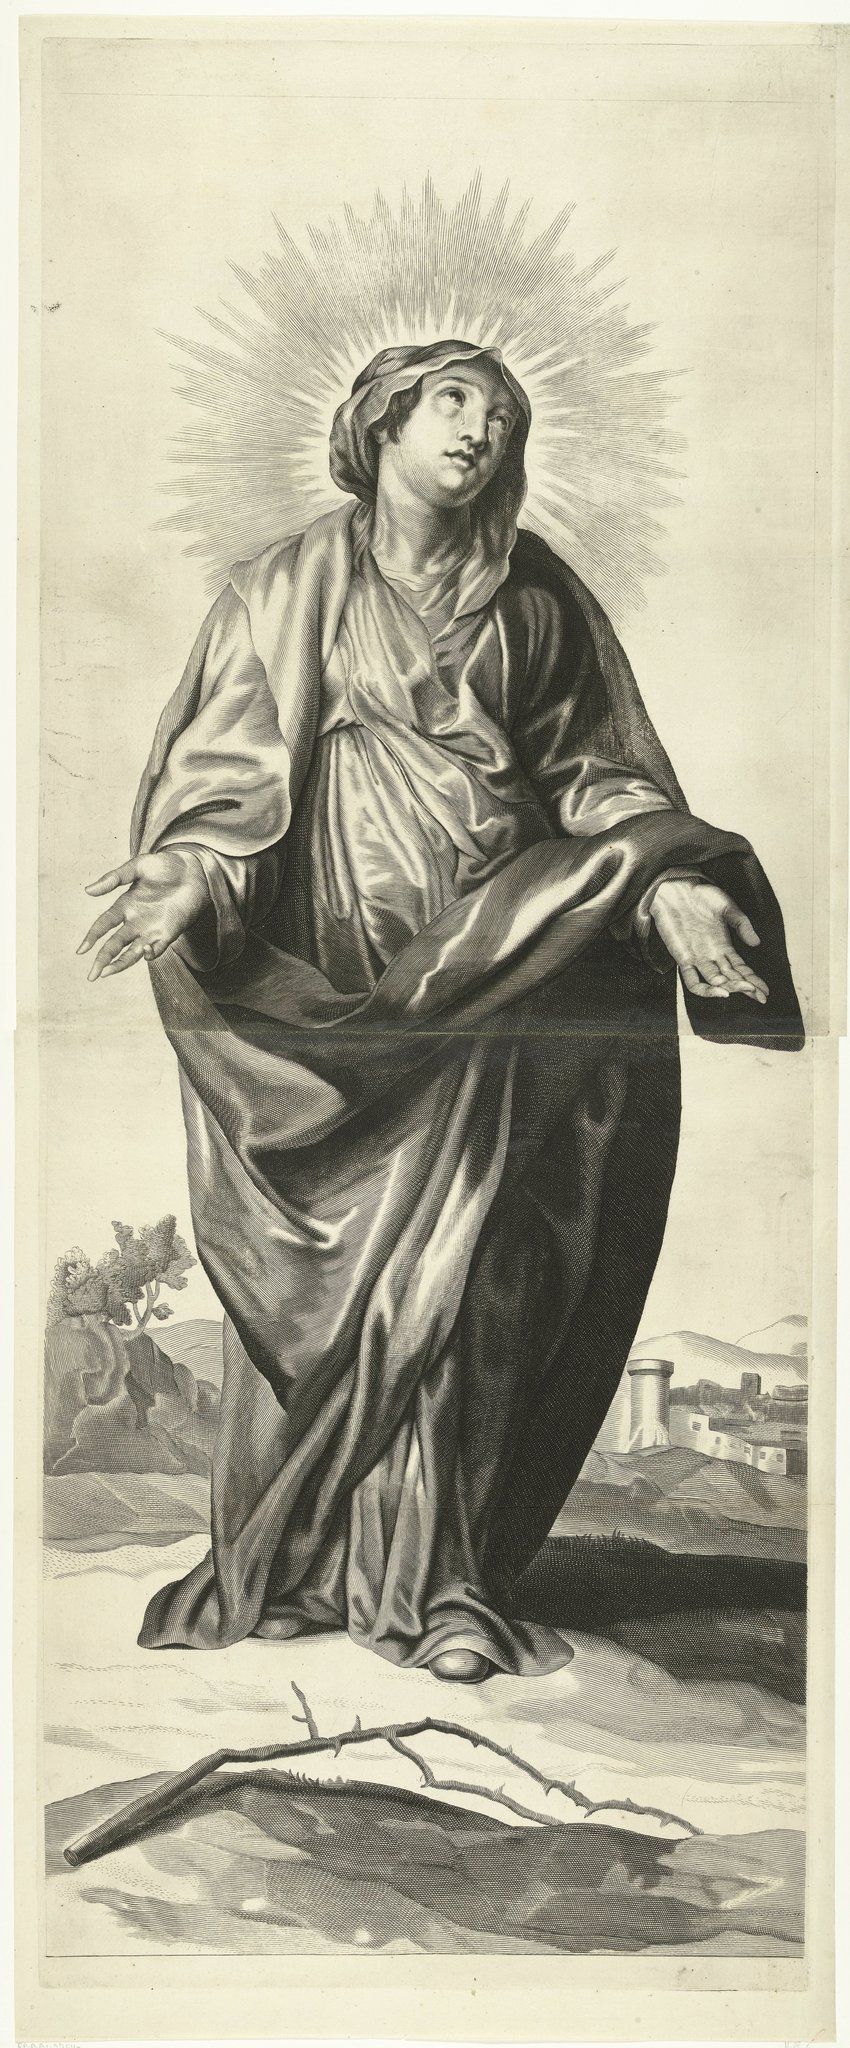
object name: print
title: Maria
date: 1650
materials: paper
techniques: engraving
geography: antwerp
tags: series of scenes from the life of mary, prospect of city, town panorama, silhouette of city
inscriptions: collector's mark: Lugt 2228, collector's mark: Lugt 240 of 1838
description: Op de voorgrond van de prent staat Maria. Haar ogen zijn naar de hemel gericht. Ze huilt. Op de achtergrond een stadsgezicht.